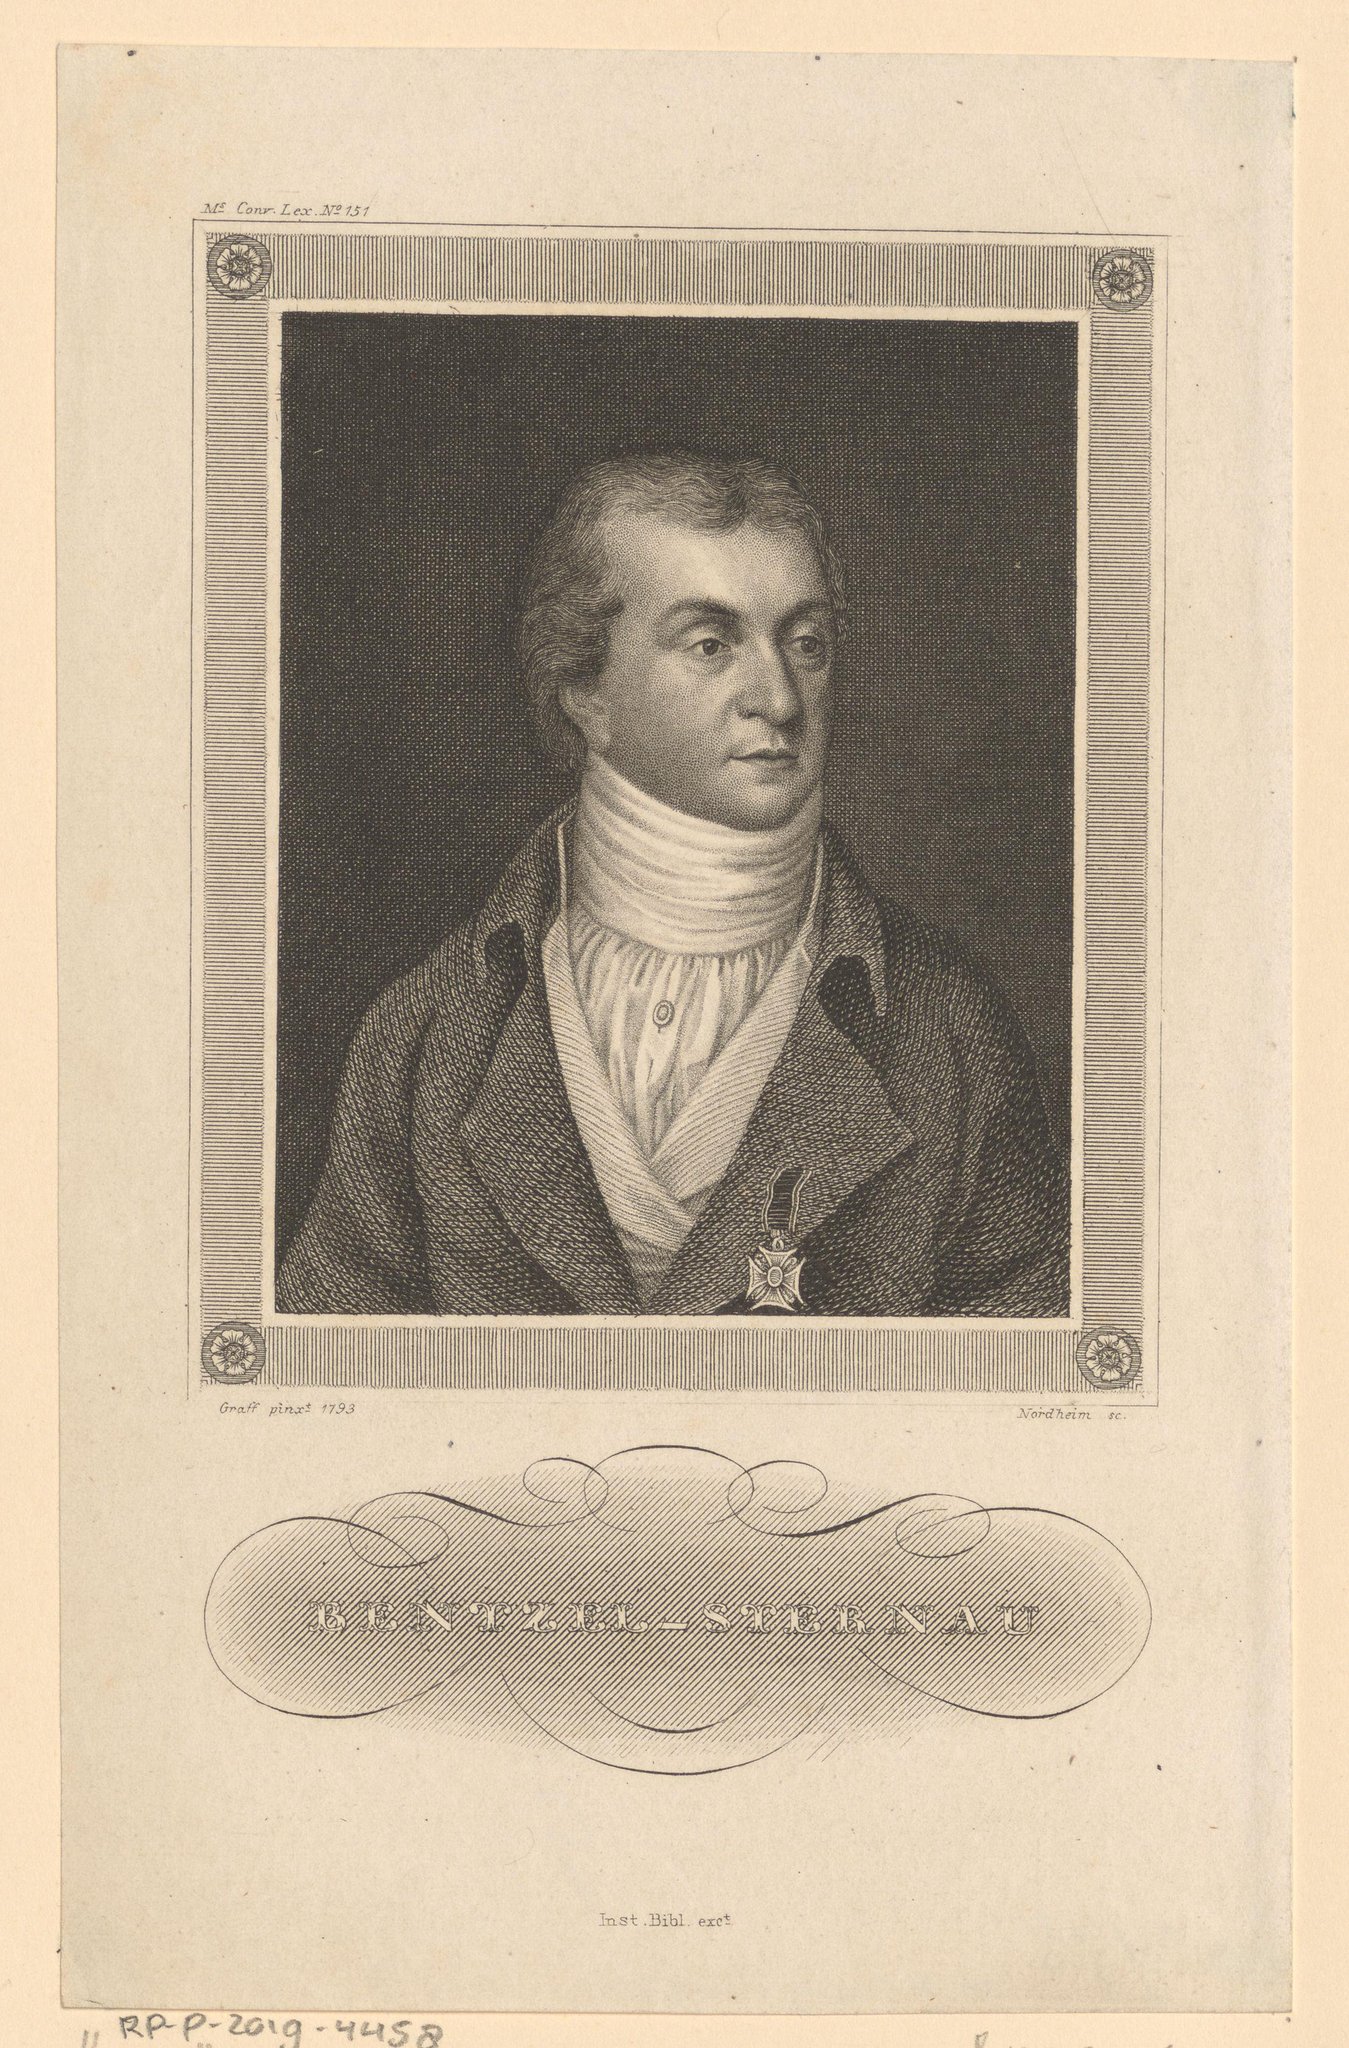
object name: book illustration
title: Portret van Carl Bentzel-Sternau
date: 1840-1855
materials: paper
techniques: engraving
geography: hildburghausen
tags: historical persons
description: Prent uit: Meyer, Joseph. Das Grosse Conversations-Lexikon für die gebildeten Stände. Hildburghausen: Bibliographisches Institut, 1840-1855.